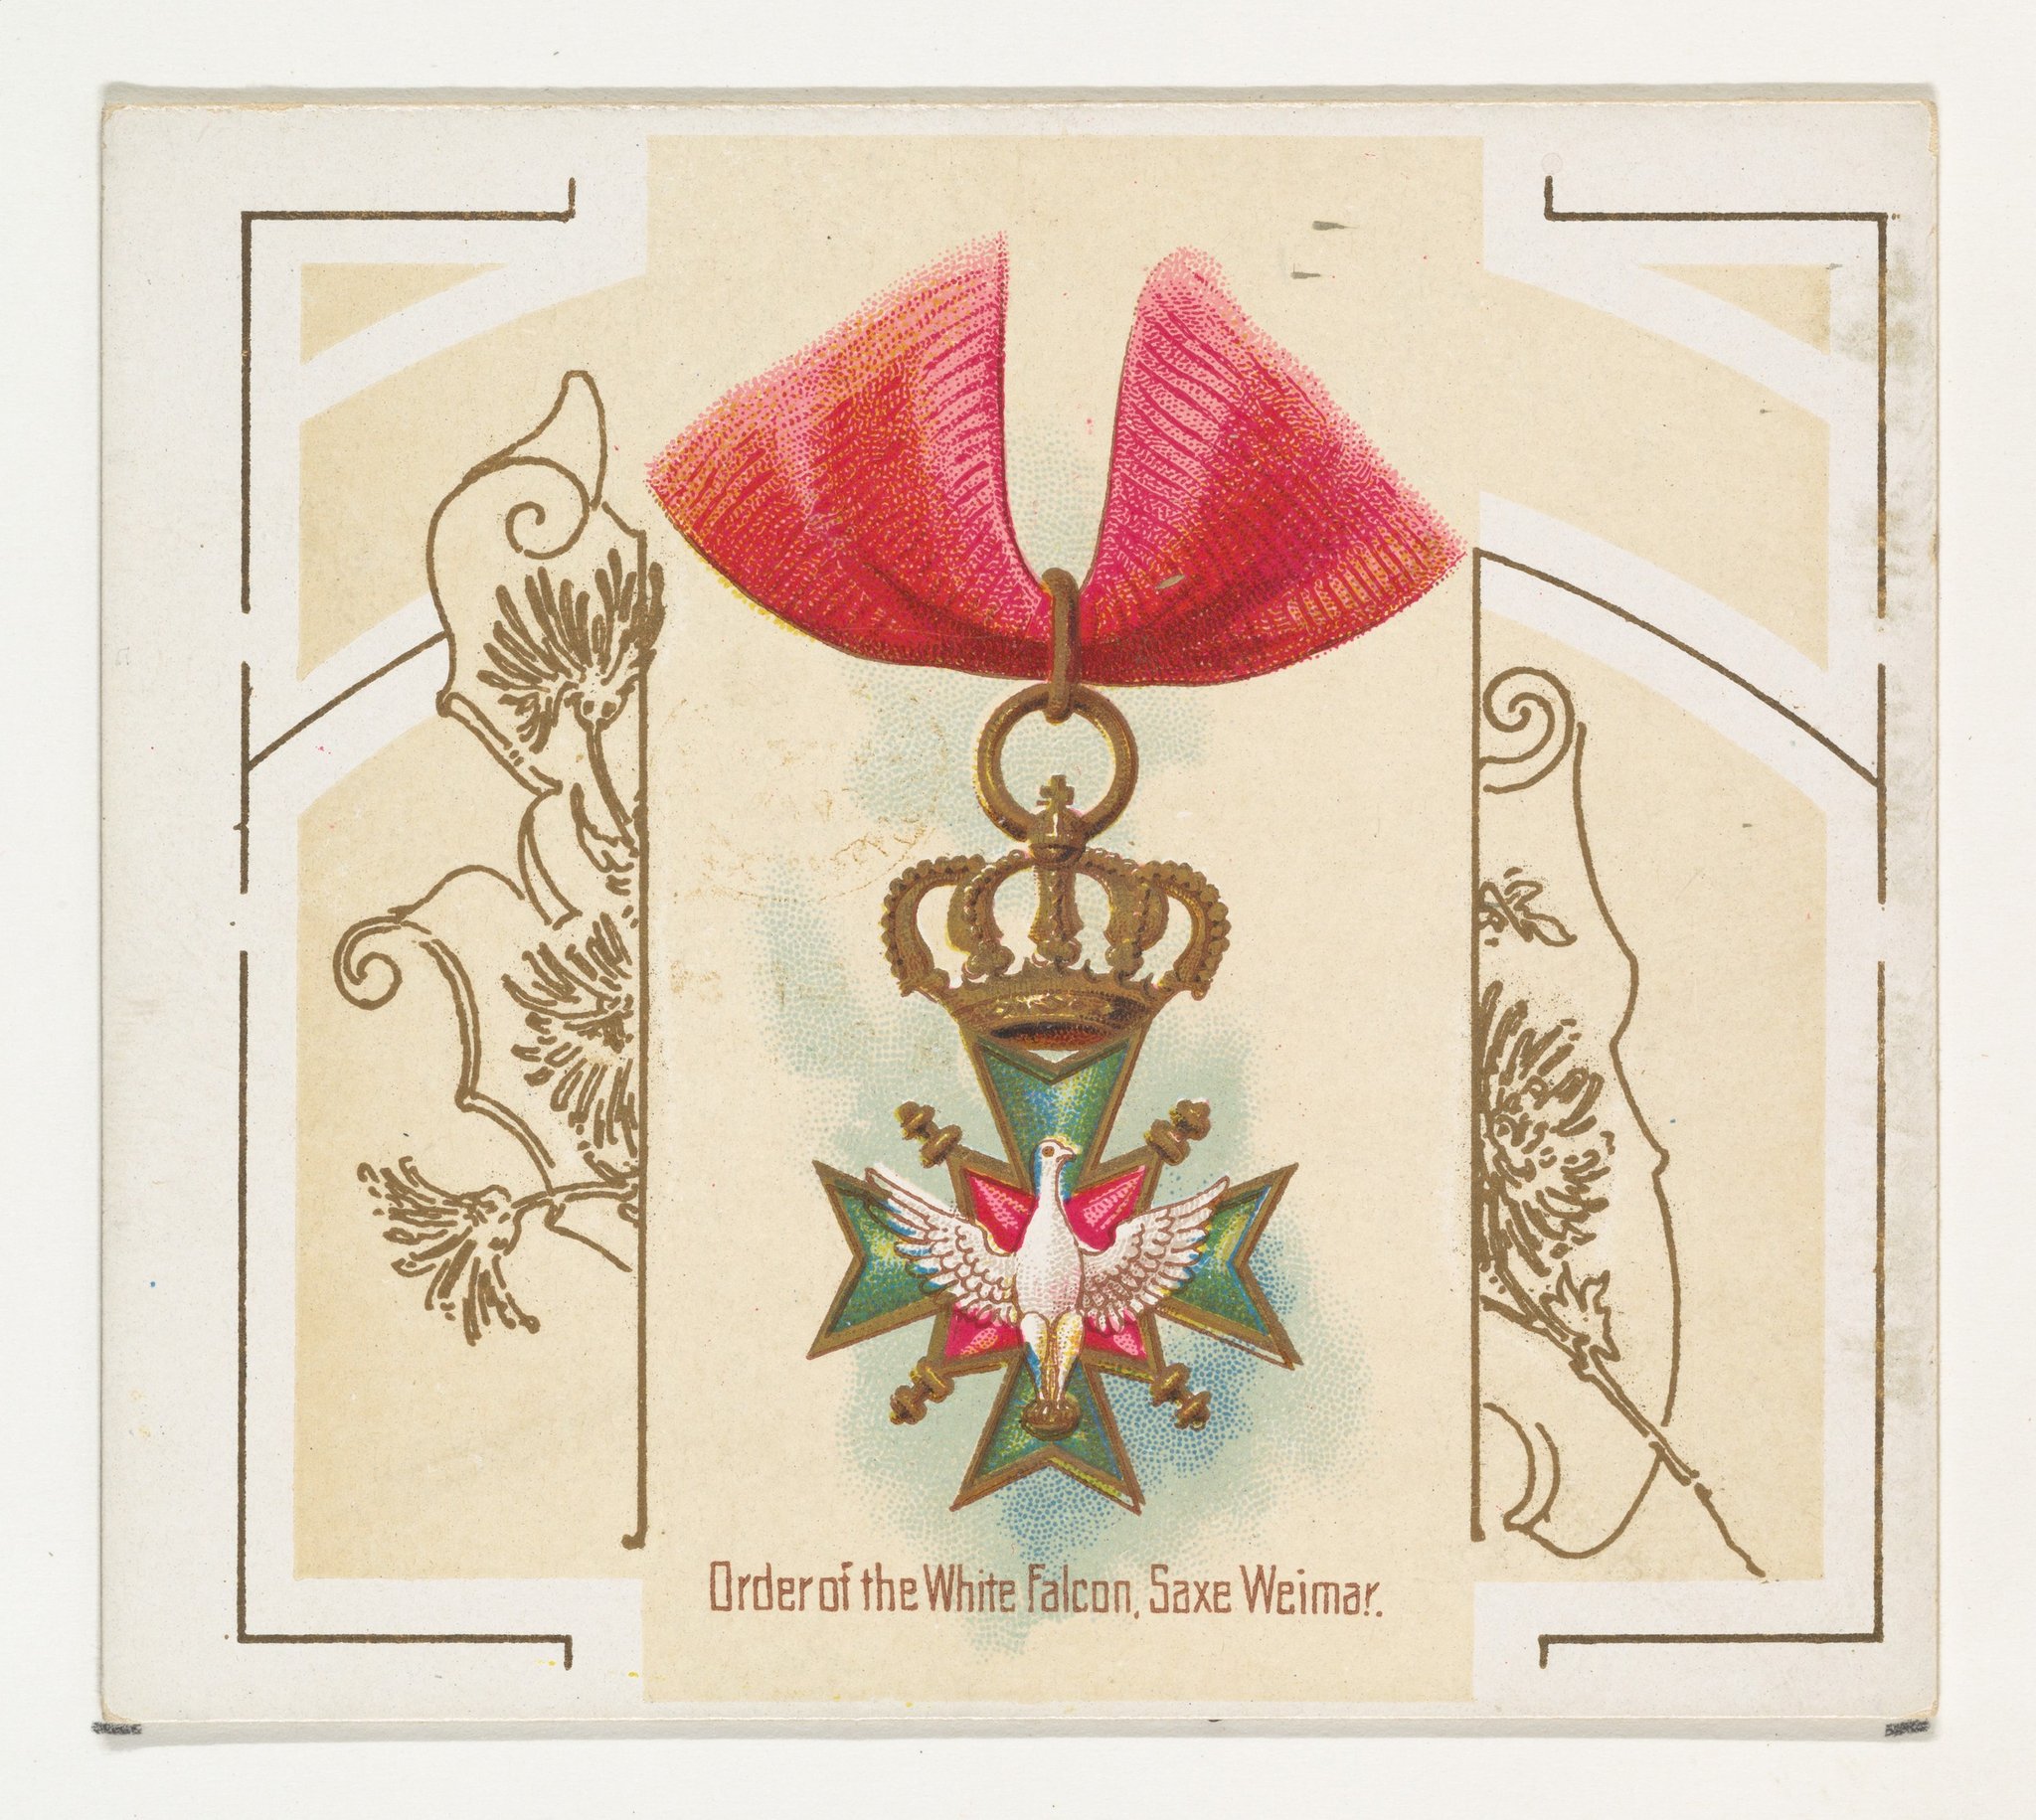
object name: print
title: Order of the White Falcon, Saxe Weimar, from the World's Decorations series (N44) for Allen & Ginter Cigarettes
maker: allen & ginter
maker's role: publisher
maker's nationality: american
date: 1890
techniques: color lithograph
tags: medals